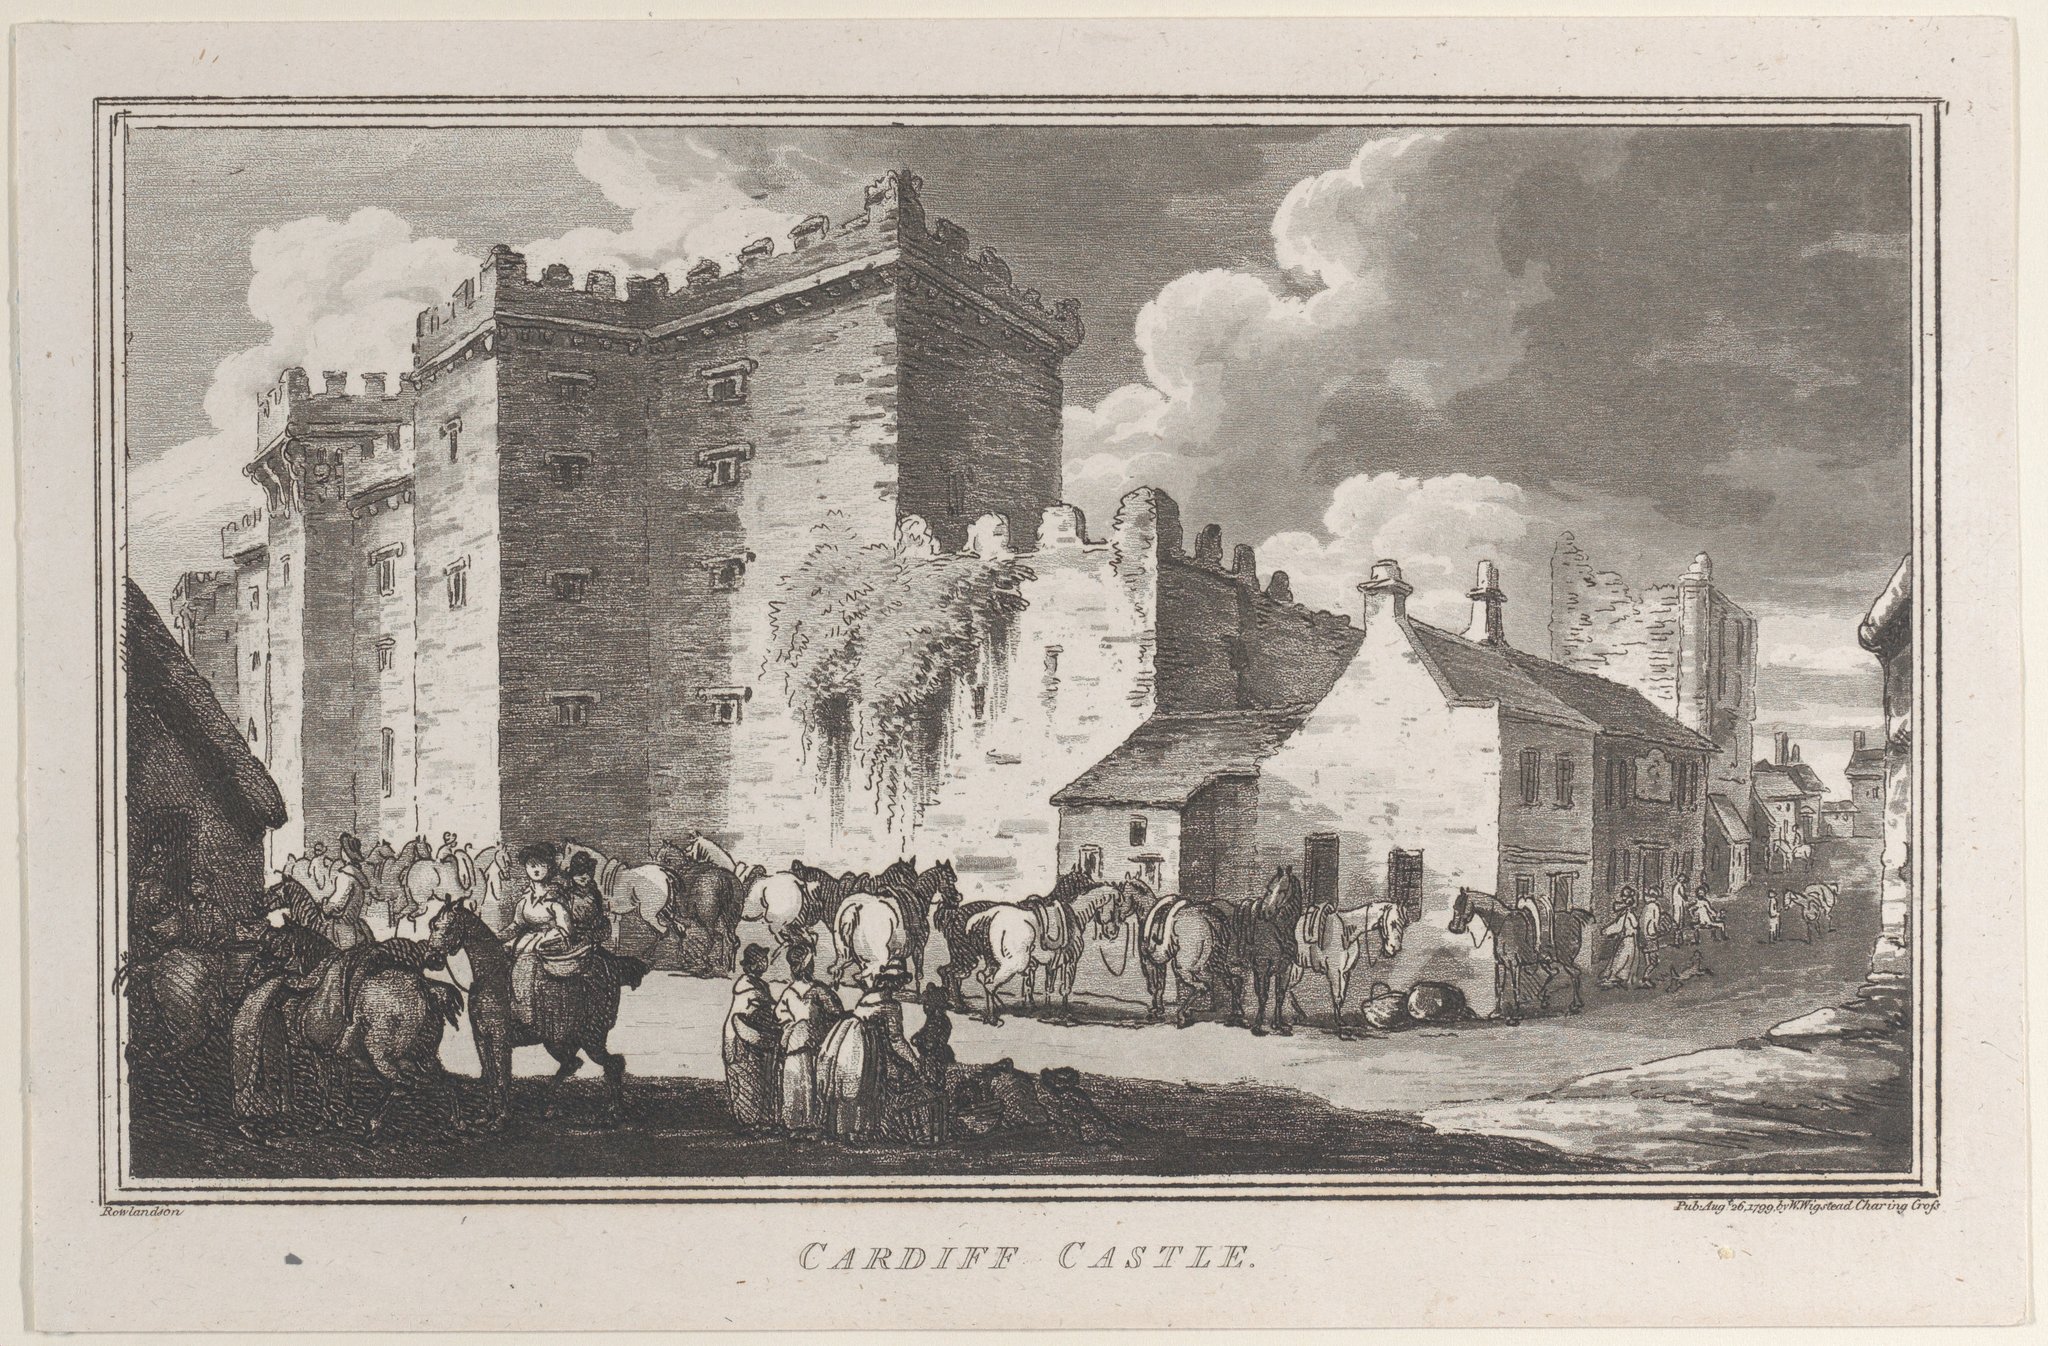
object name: print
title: Cardiff Castle, from "Remarks on a Tour to North and South Wales, in the year 1797"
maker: john hill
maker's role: artist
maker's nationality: british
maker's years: 1714-1775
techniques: aquatint, etching